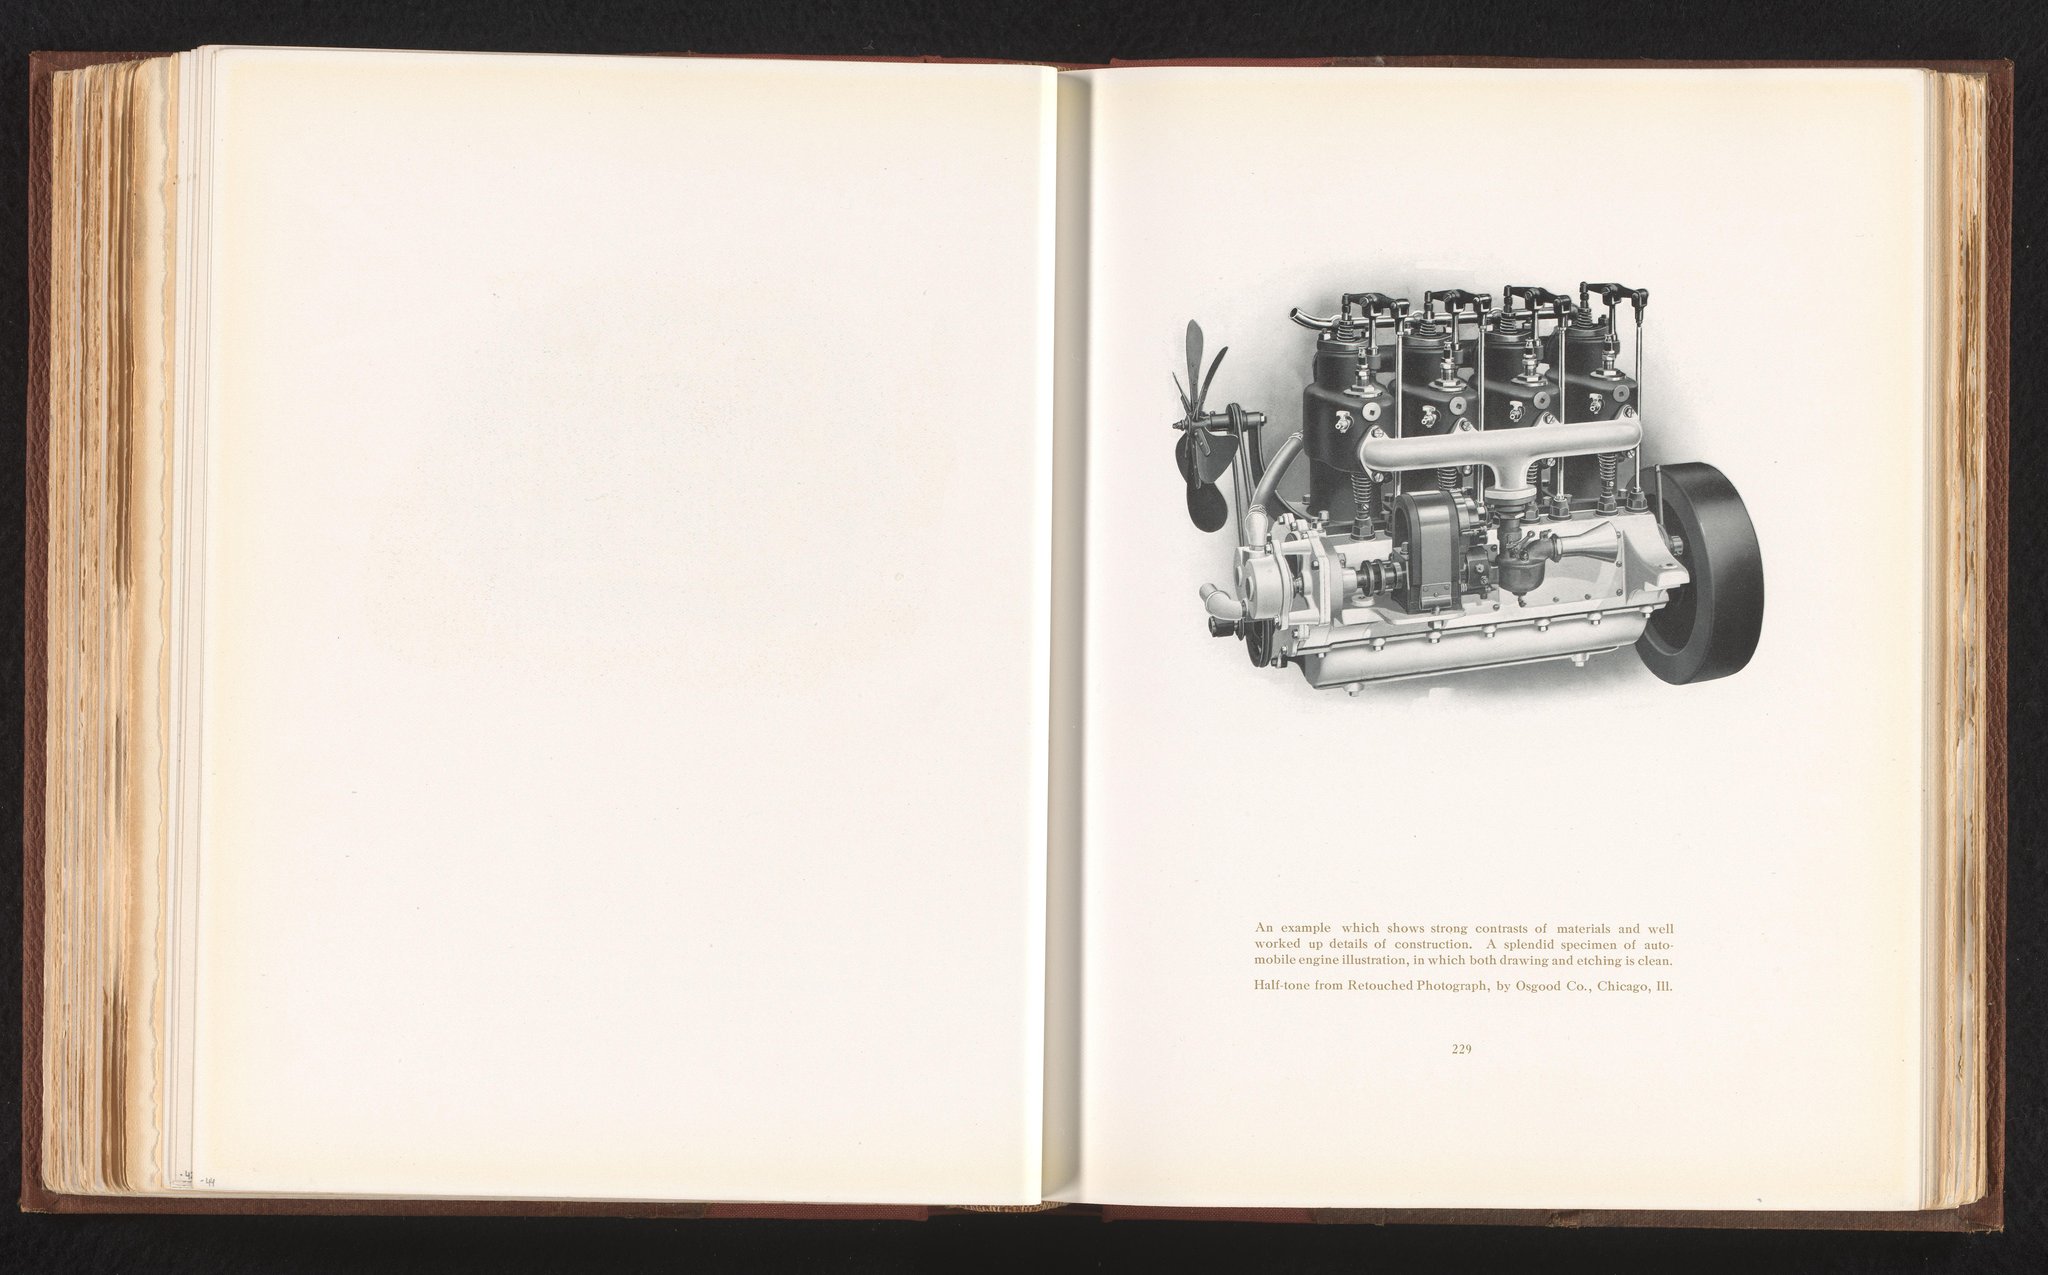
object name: photomechanical print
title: Mechanisch onderdeel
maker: Anonymous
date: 1904-1909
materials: paper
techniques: autotype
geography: chicago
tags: mechanics